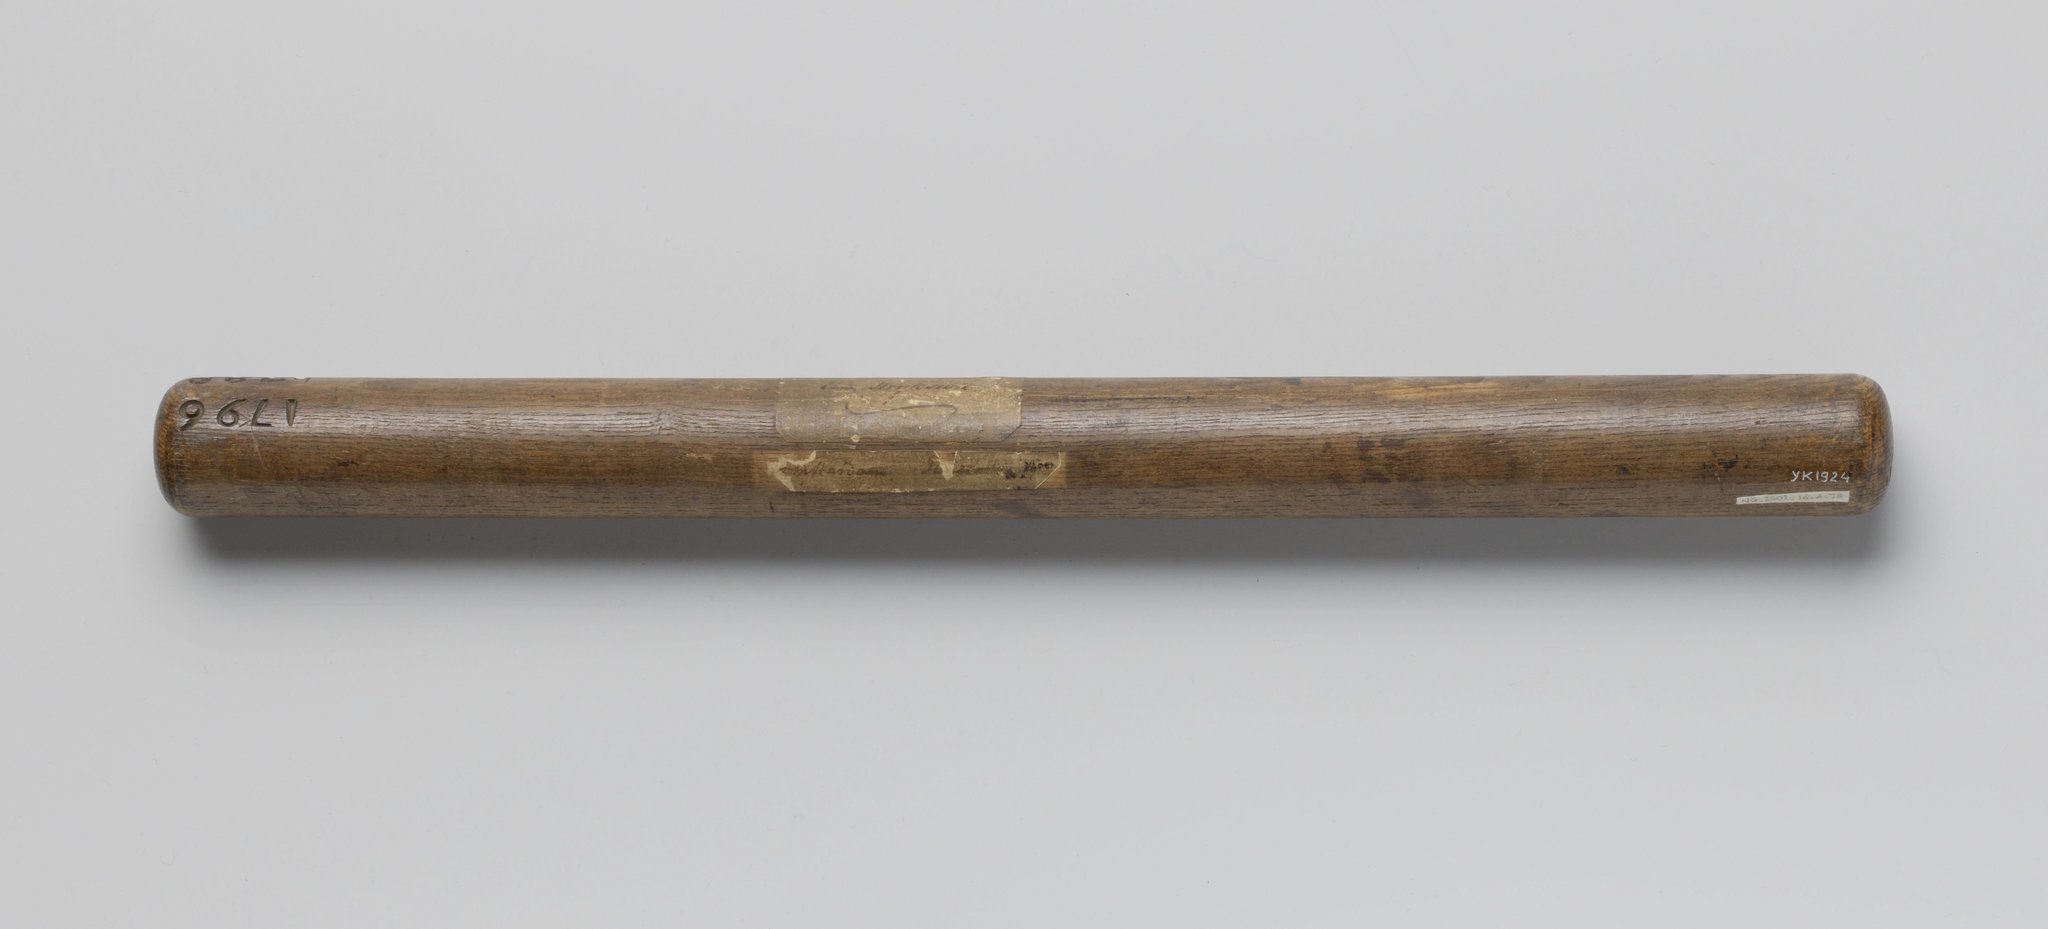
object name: strijker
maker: Anonymous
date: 1796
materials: wood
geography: amsterdam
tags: amsterdam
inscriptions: number: ‘229 / 24’, inscription: ‘Amsterdam / Een strijkstok’, number: ‘12’, date: ‘1796 / 1797 / 1798 / 1799 / 1800’, inscription: ‘d'Amsterdam ...’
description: Eikenhouten strijker, v.z.v. dateringen en etiketten.